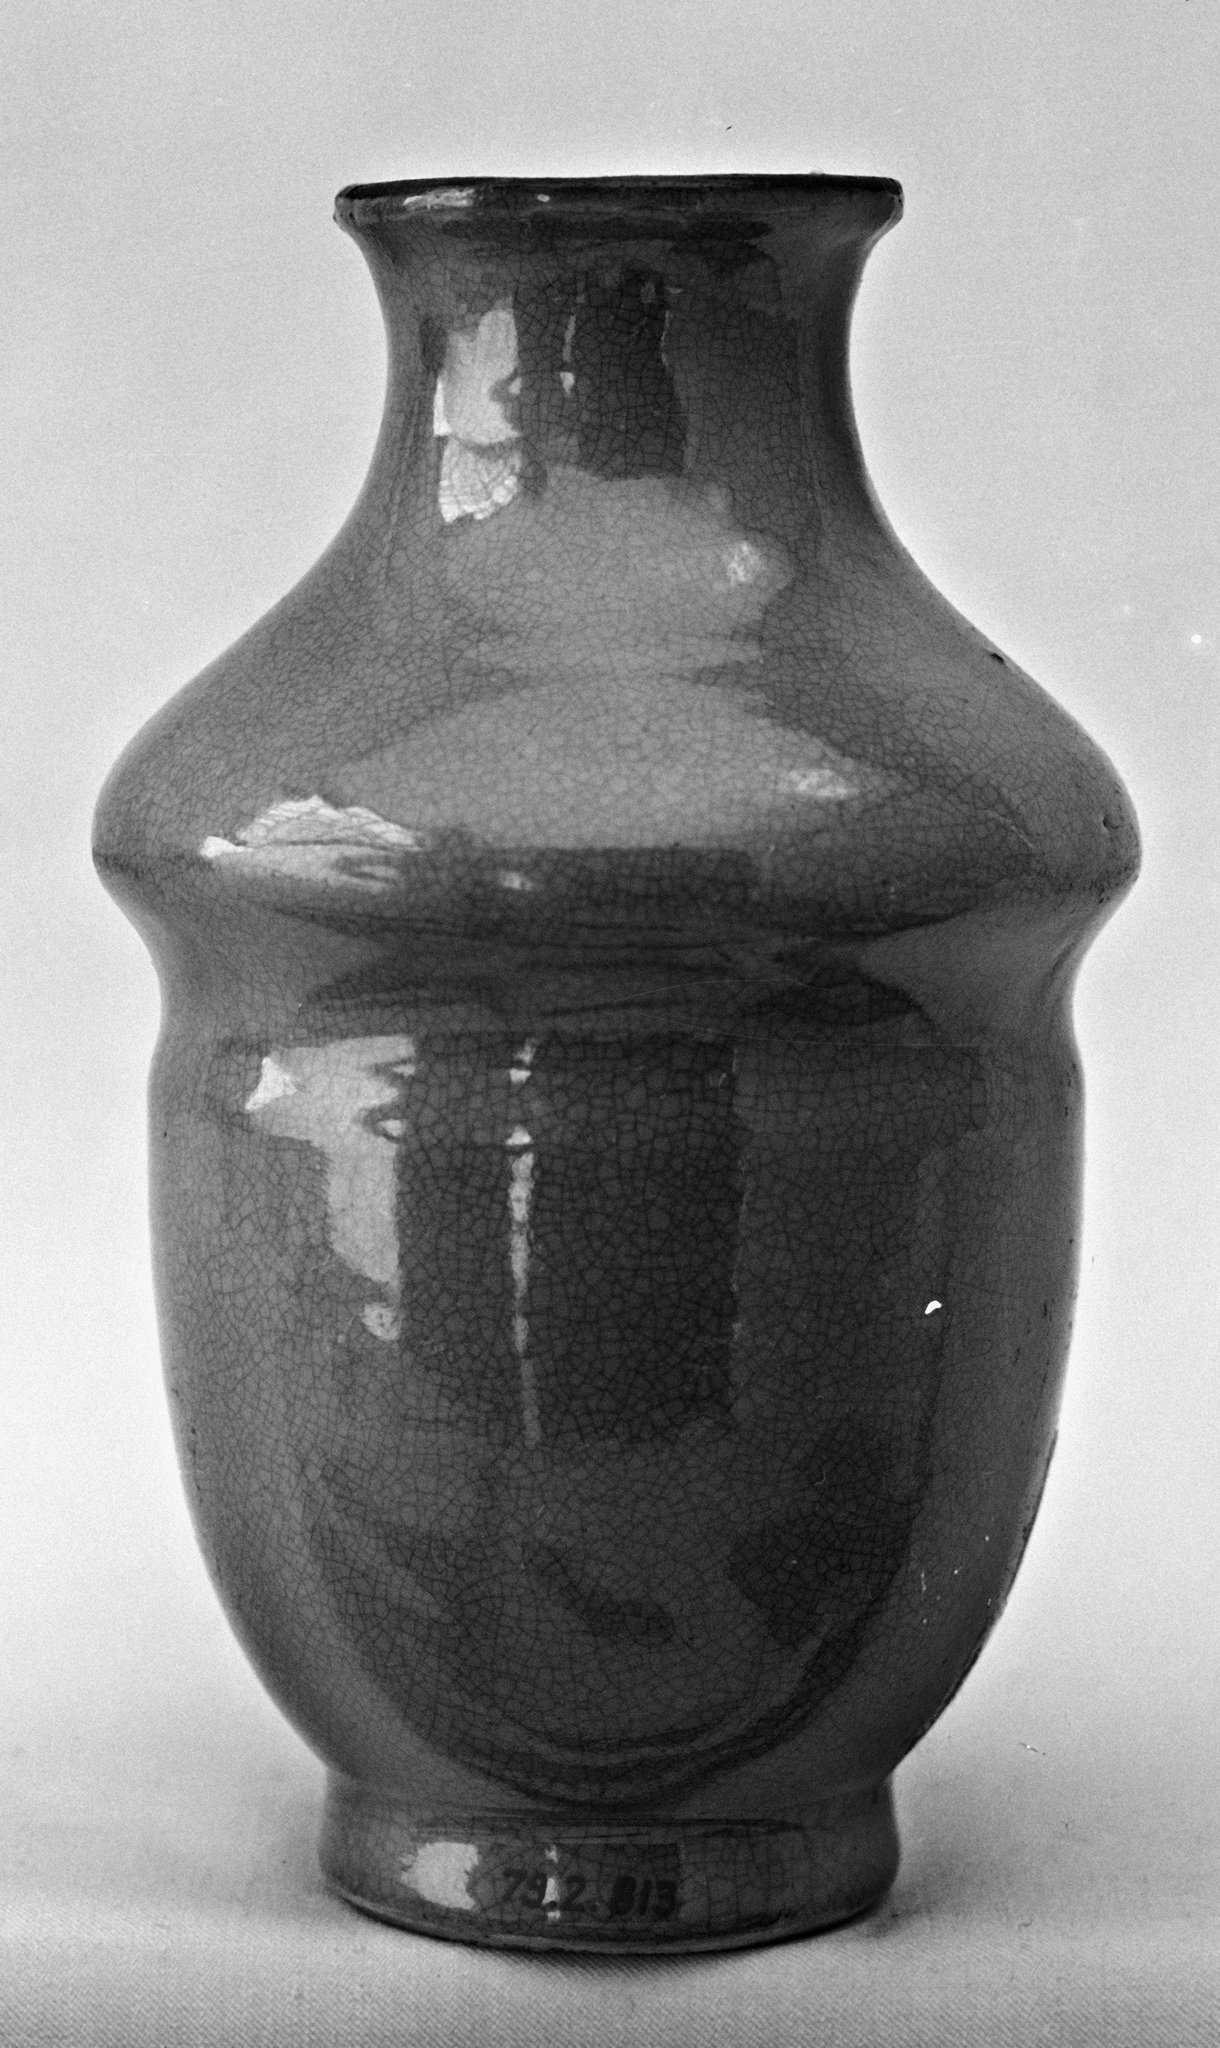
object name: vase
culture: chinese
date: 1767-1833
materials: glaze, porcelain